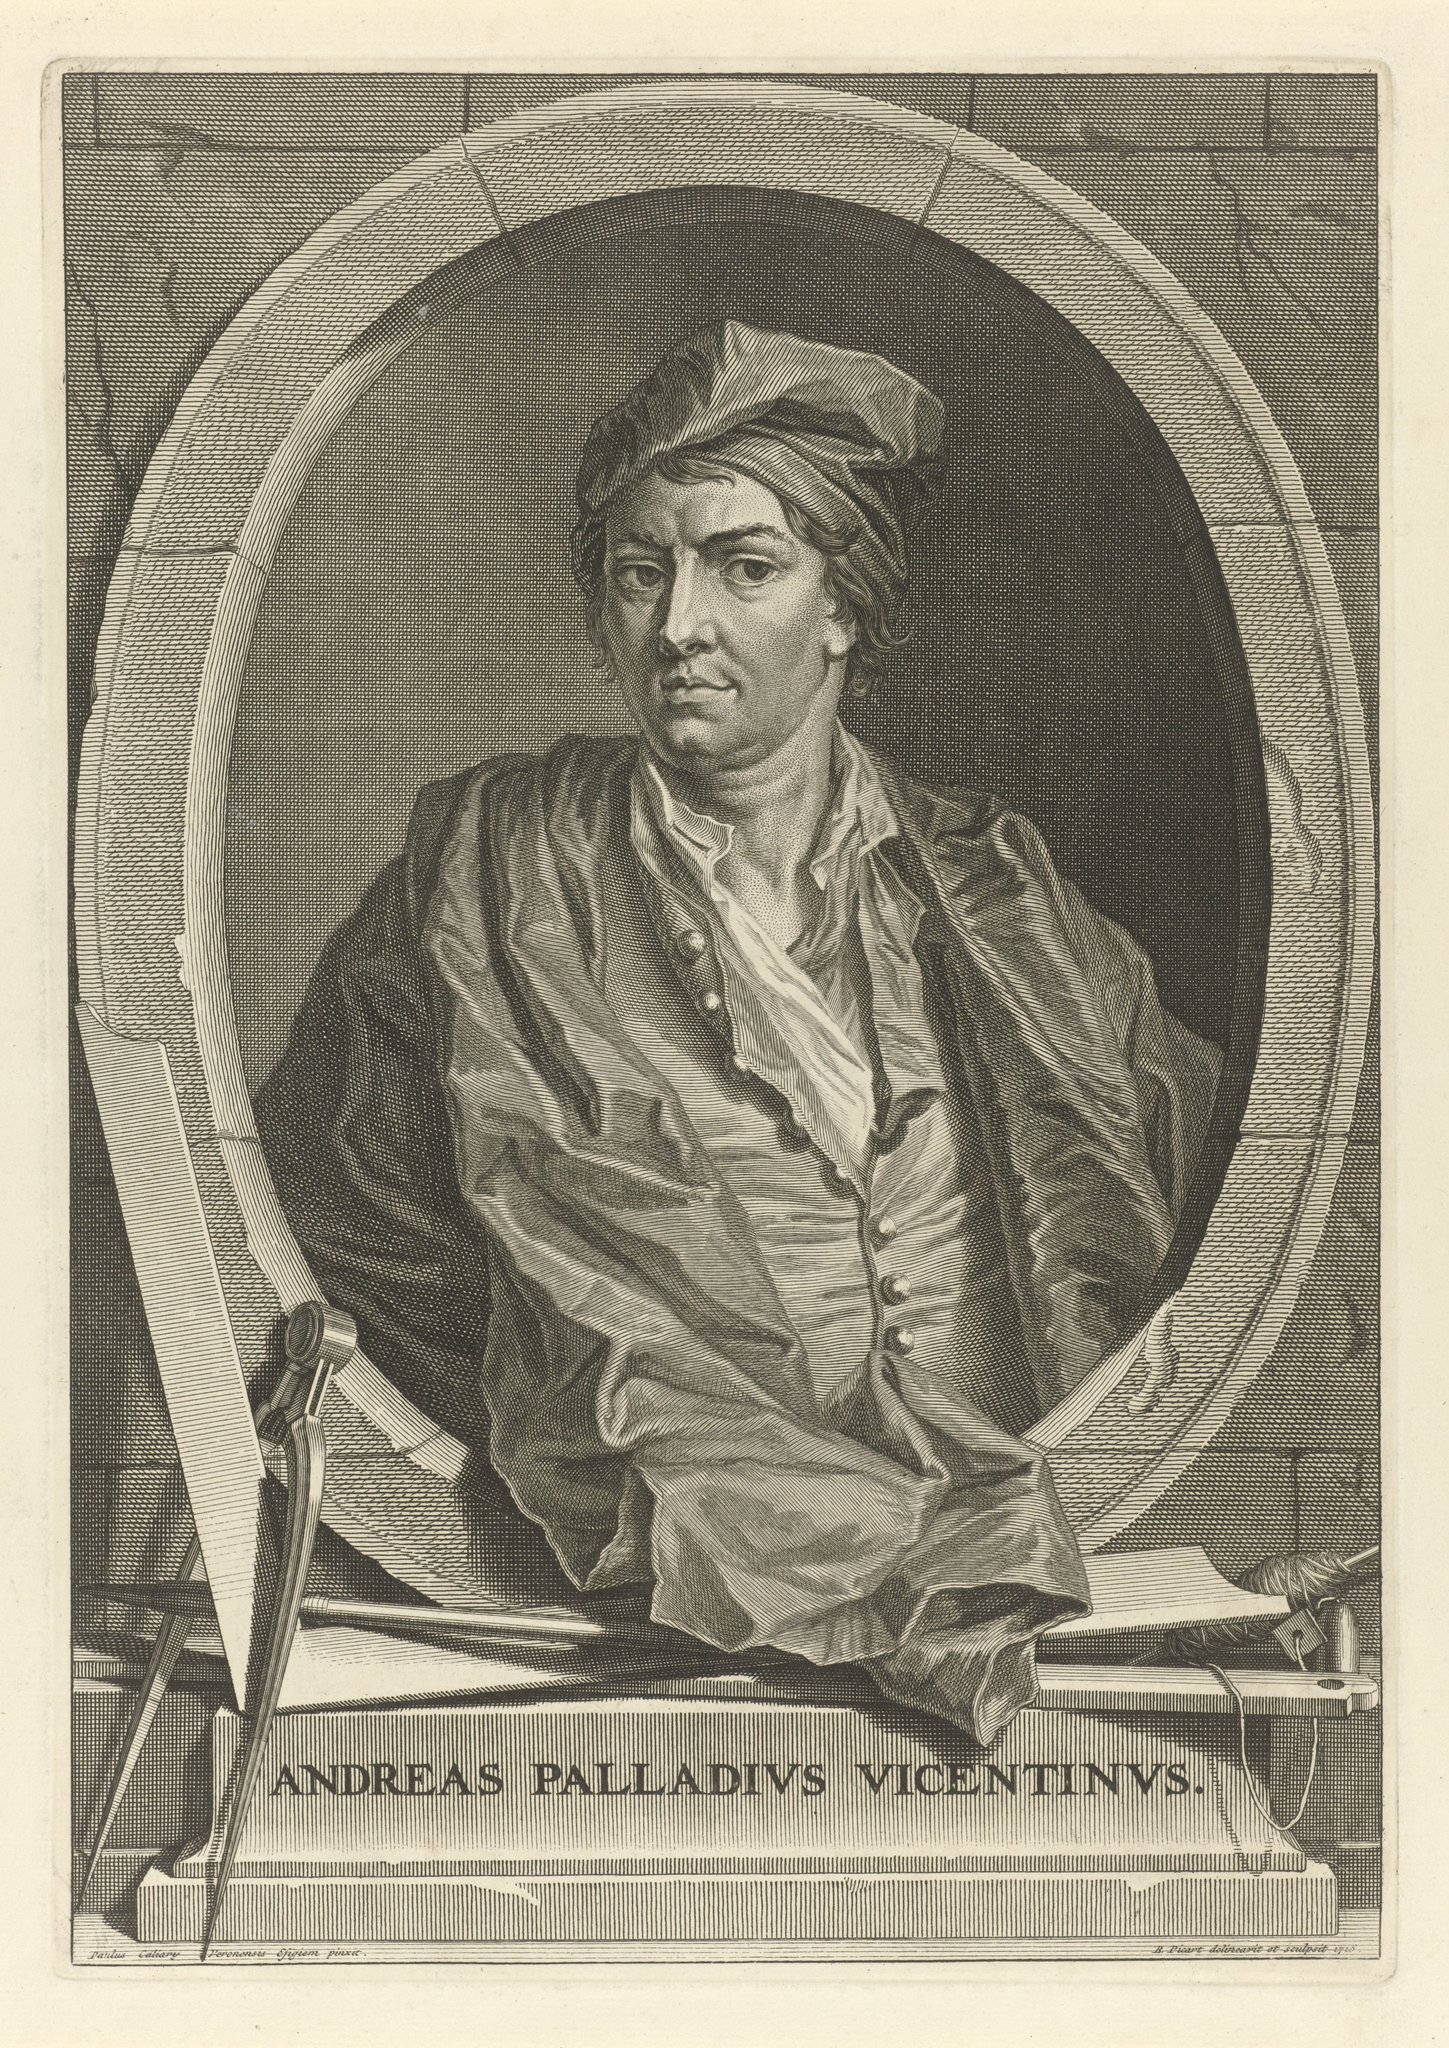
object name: print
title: Portret van Andrea Palladio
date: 1716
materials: paper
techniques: engraving, etching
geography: amsterdam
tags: andrea palladio, portrait, self-portrait of architect, portrait, self-portrait of artist, tools, implements of architect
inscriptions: collector's mark: Lugt 2228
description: Portret van de Italiaanse architect Andrea di Pietro della Gondola (Palladio). Op de piëdestal diverse attributen waaronder een passer.